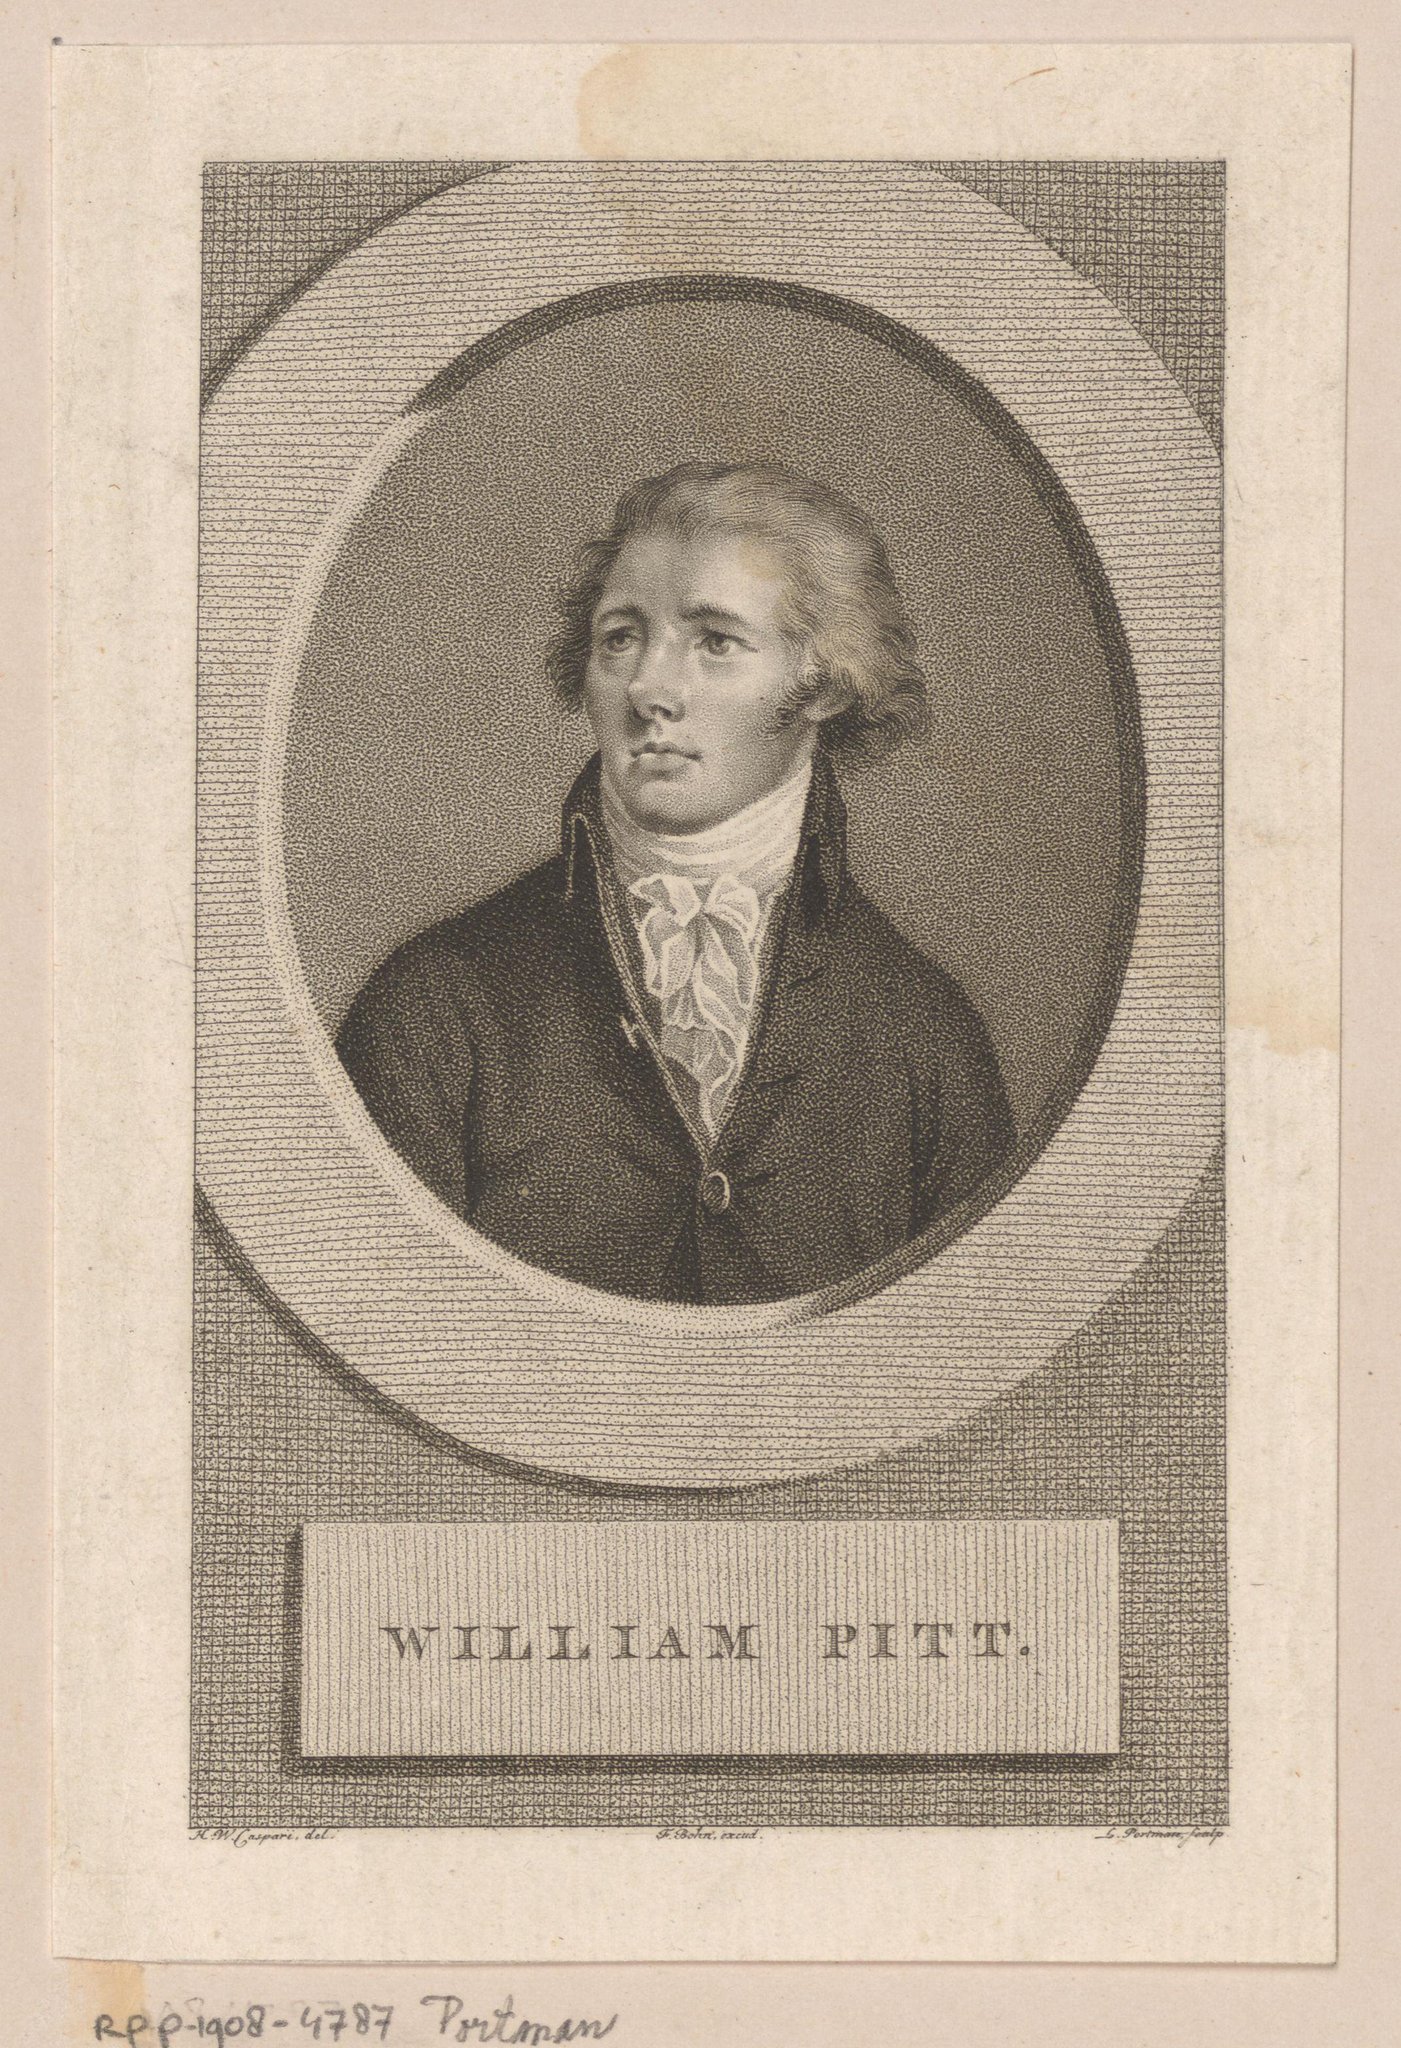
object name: print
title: Portret van William Pitt II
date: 1794-1819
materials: paper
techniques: engraving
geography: haarlem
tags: london, politician, adult man, historical persons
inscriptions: collector's mark: Lugt 2228